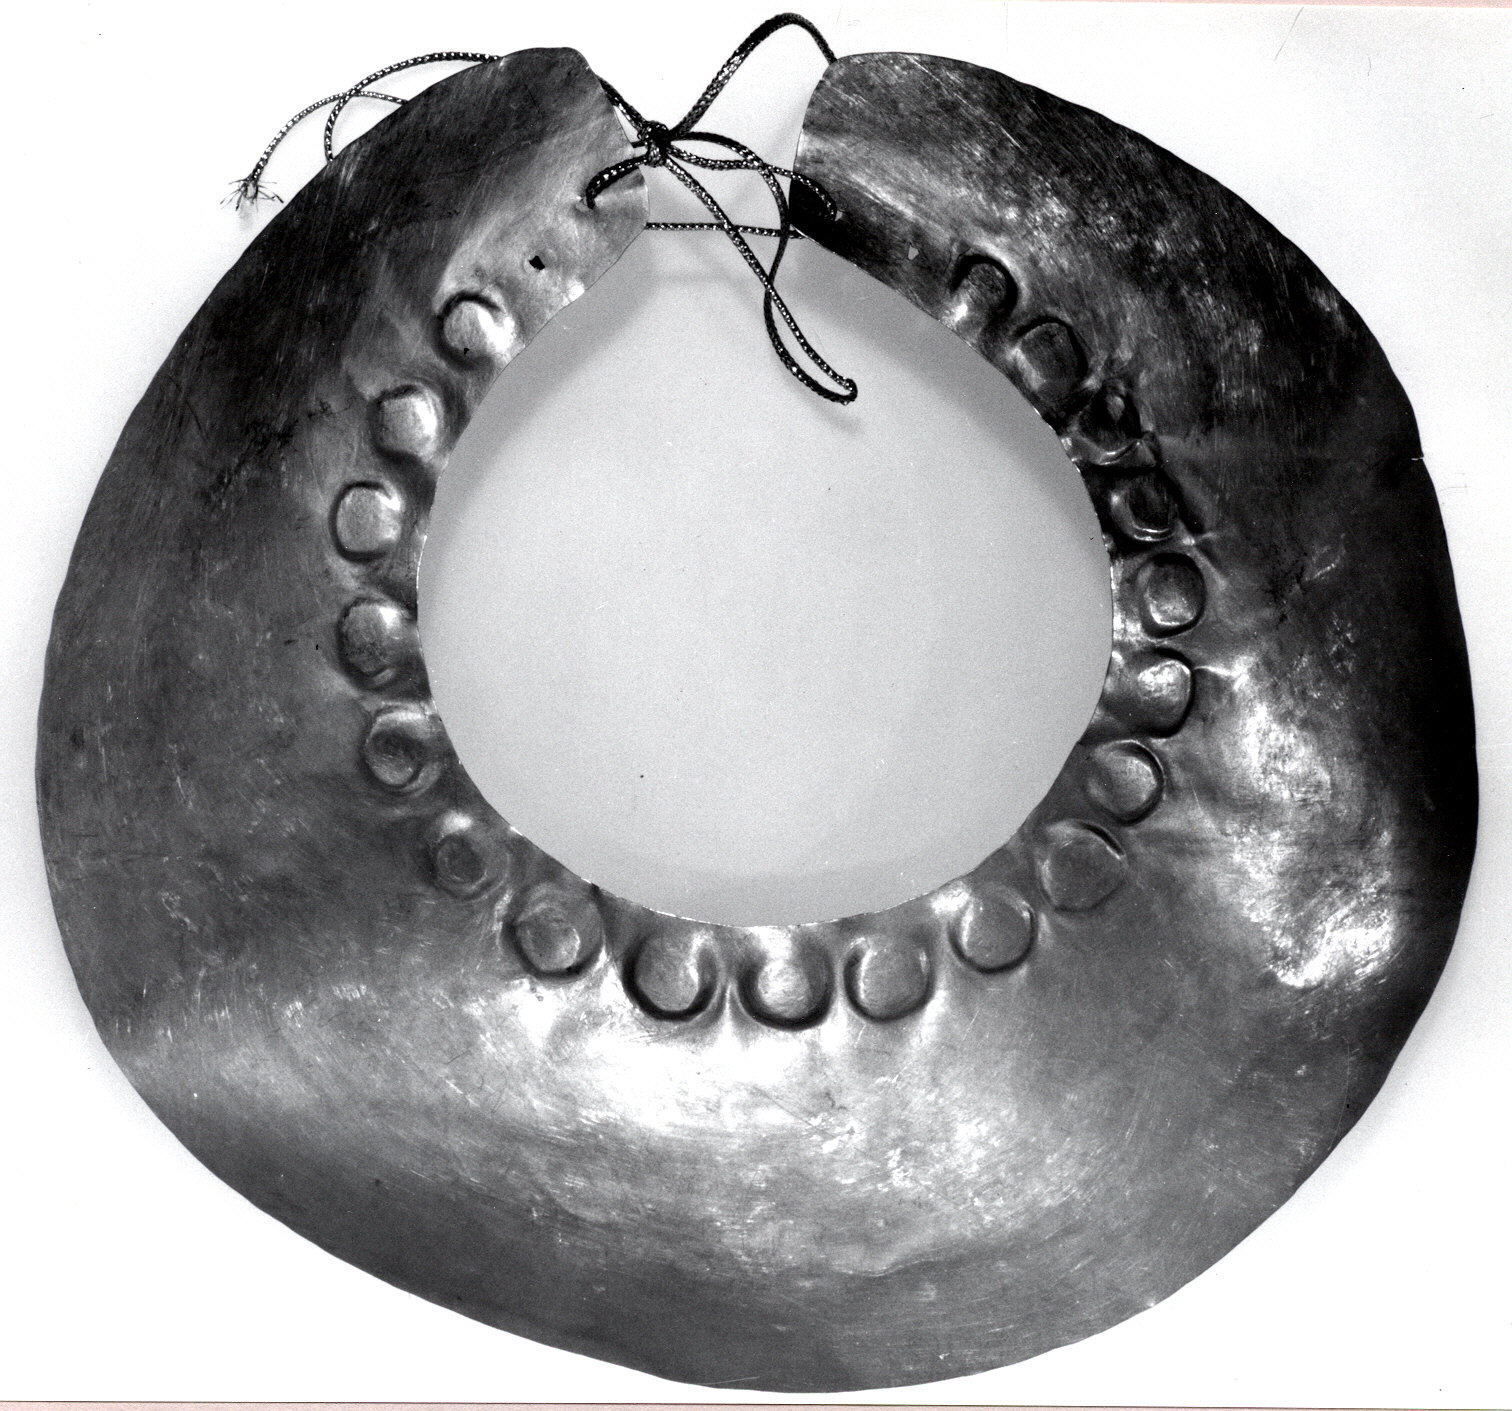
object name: collar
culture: costa rican or panamanian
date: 501-1200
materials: gold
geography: costa rica